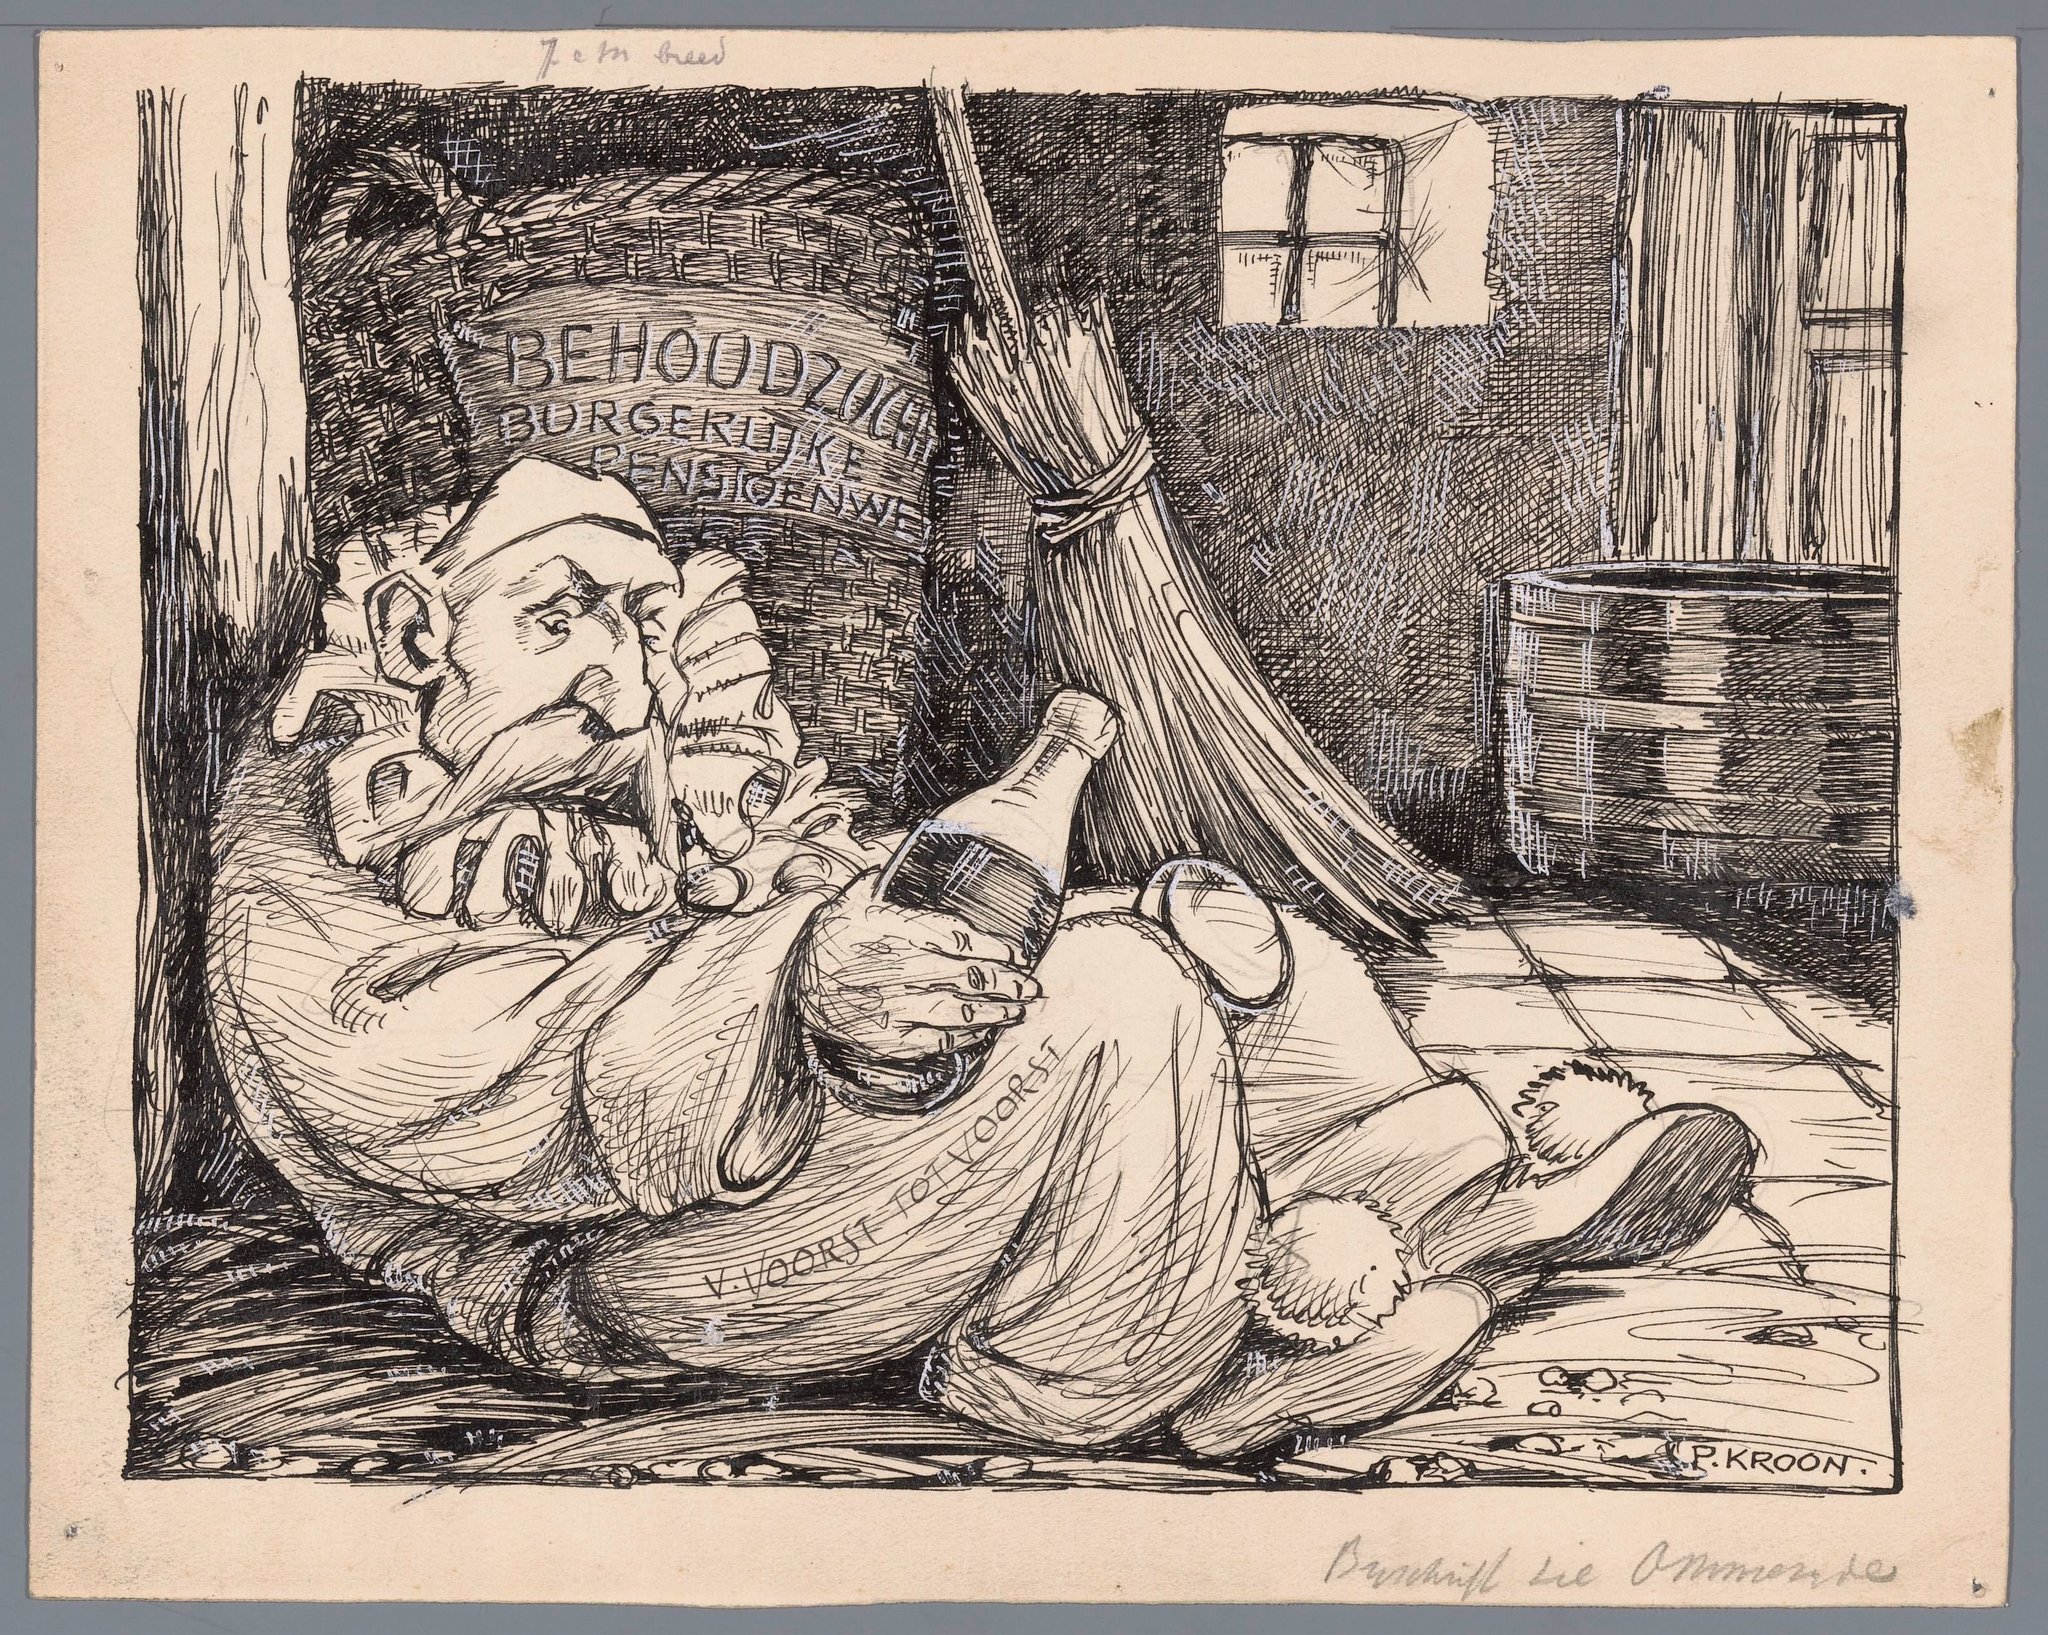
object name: drawing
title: Baron van Voorst tot Voorst als carnavalsganger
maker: patricq kroon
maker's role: draughtsman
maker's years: 1862-1941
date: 1915-1930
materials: paper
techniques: pen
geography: netherlands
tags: carnival, shrovetide (non-liturgical celebration), alcoholic drinks, political caricatures and satires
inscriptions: number: ‘18130’, inscription: ‘Carneval, of de verworpen Burgerlijke pensioenwetten. Eerste Kamer - Pierrot (na zijn escapades): sapristi! Après nous le déluge’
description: Baron van Voorst tot Voorst verdrinkt als carnavalsganger verkleed als Pierrot zijn verdriet na het verwerpen van de pensioenwetten. Ontwerp voor een politieke spotprent.